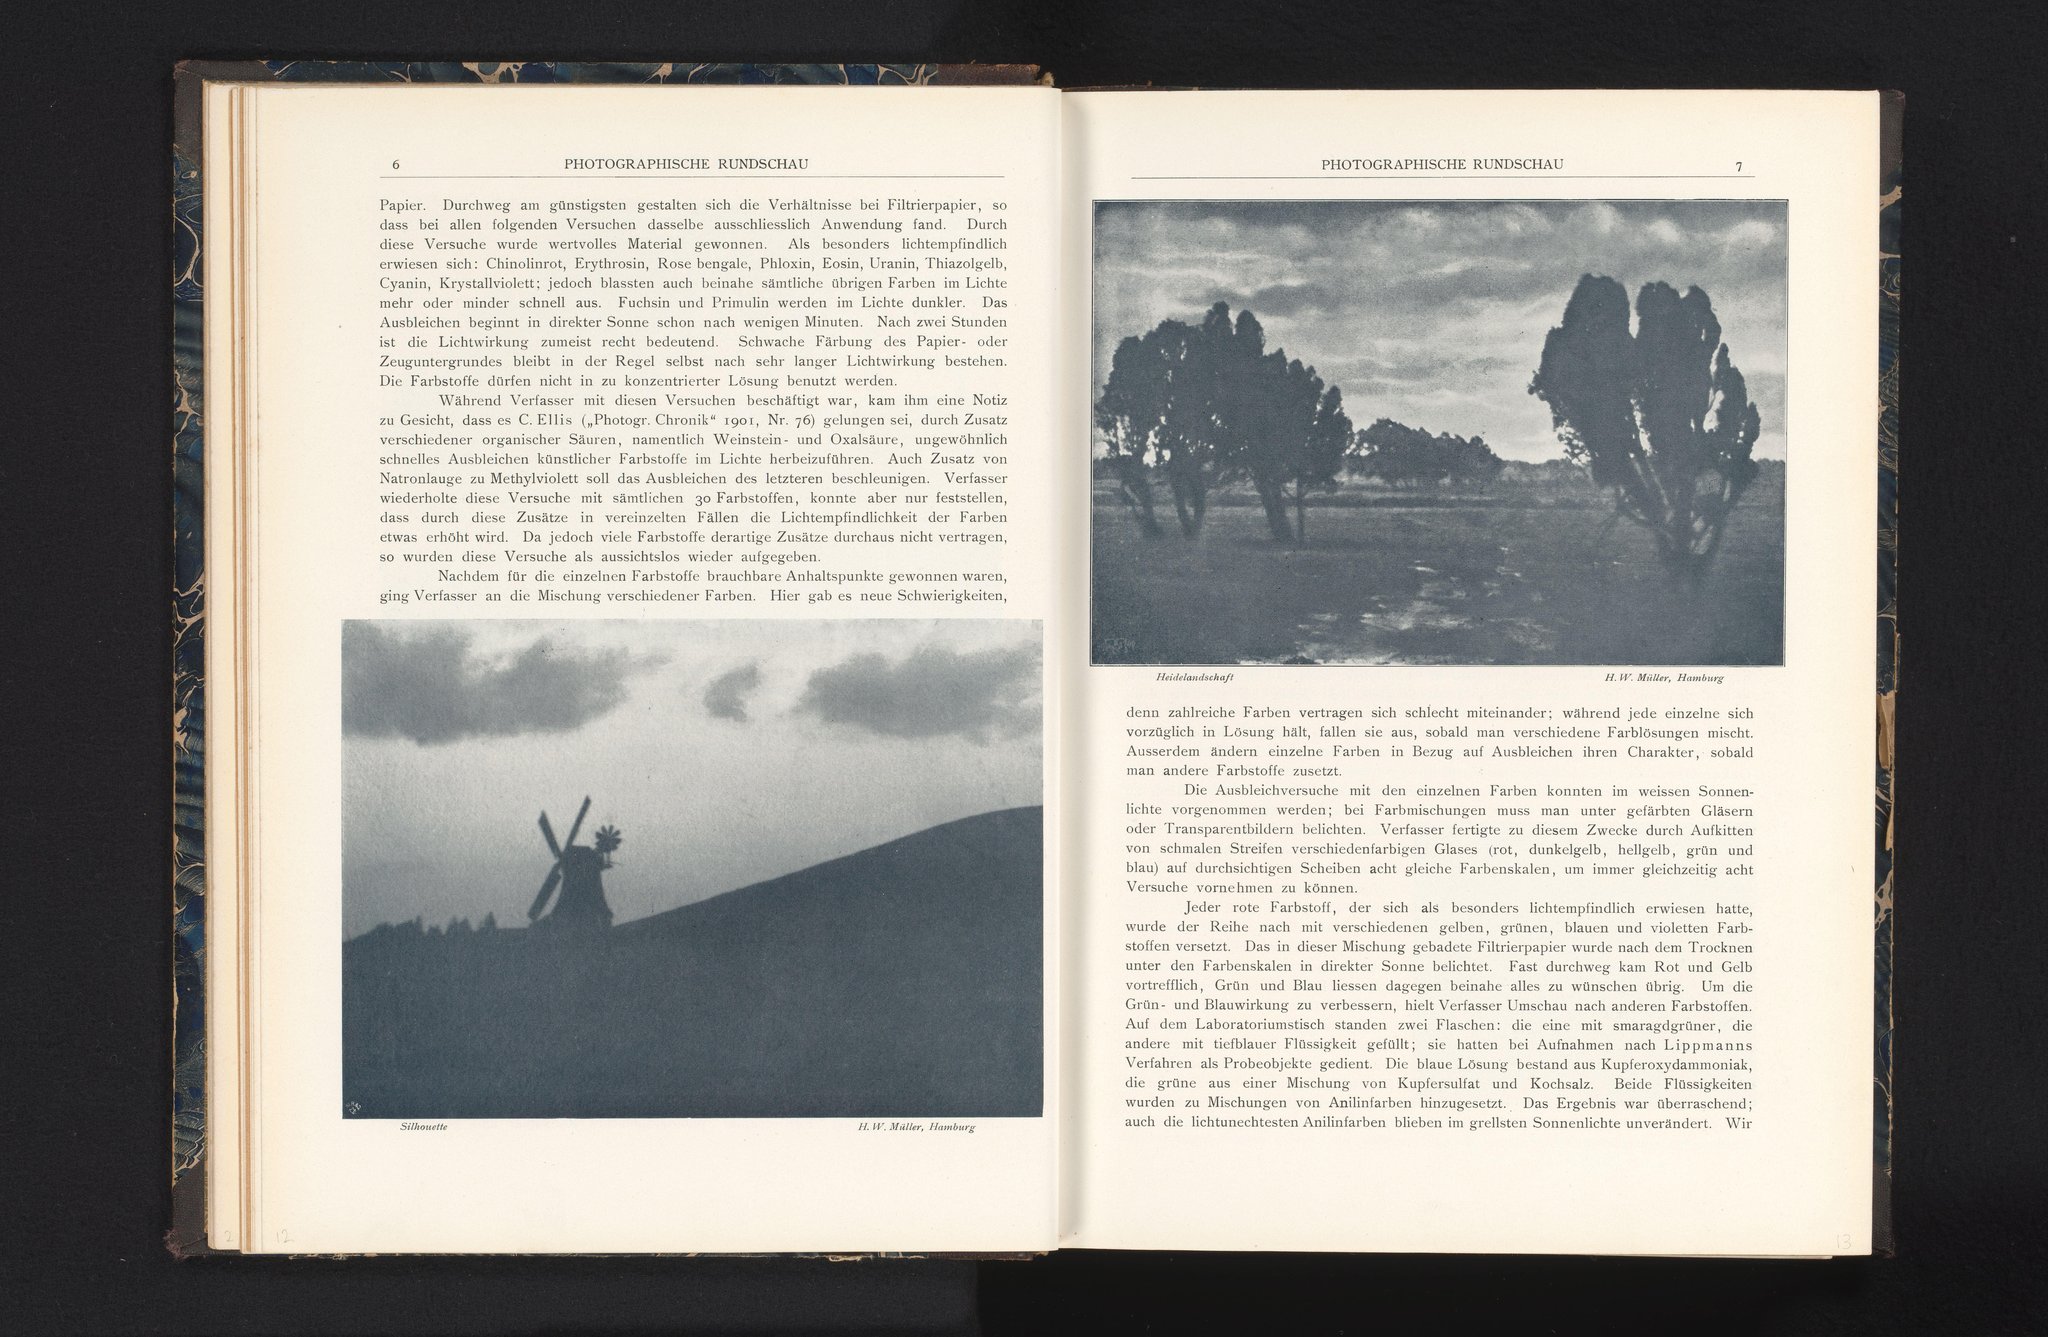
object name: page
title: Gezicht op een molen onderaan een heuvel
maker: h.w. müller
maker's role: fotograaf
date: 1897-1902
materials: paper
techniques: autotype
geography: berlin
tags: windmill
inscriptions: monogram: ‘MR&C’